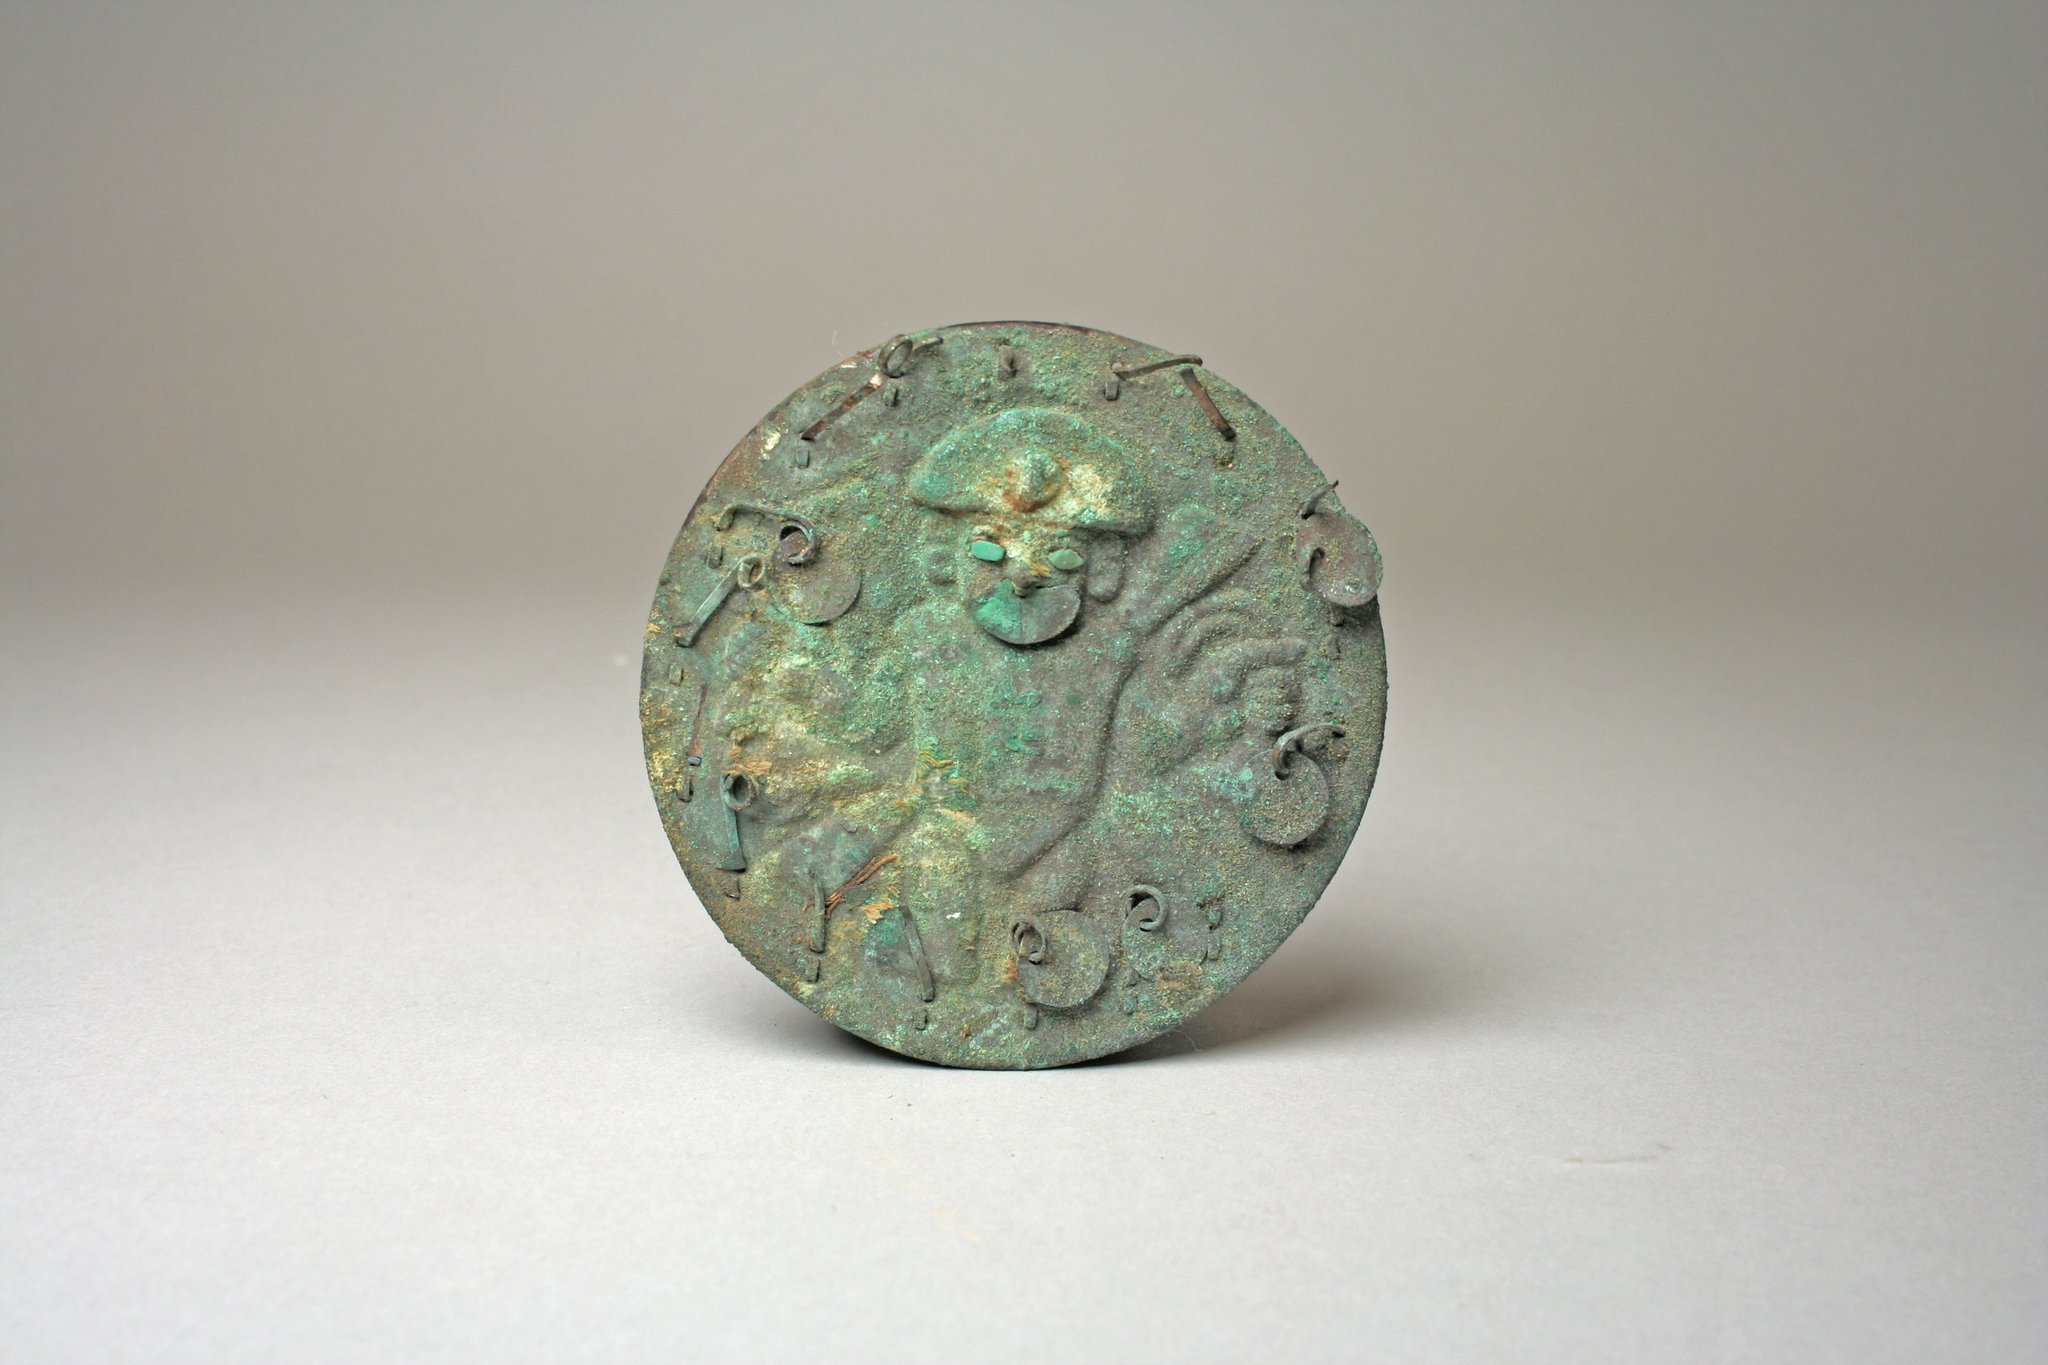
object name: earflare frontal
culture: moche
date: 501-700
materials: gilt copper, stone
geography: peru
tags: faces